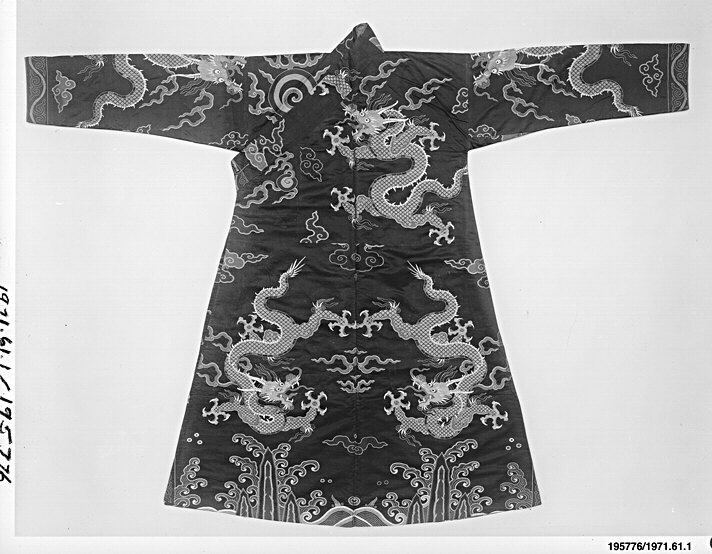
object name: robe, lay aristocrat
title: Robe for Lay Aristocrat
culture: tibetan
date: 1901-1933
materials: metal thread, silk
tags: dragons